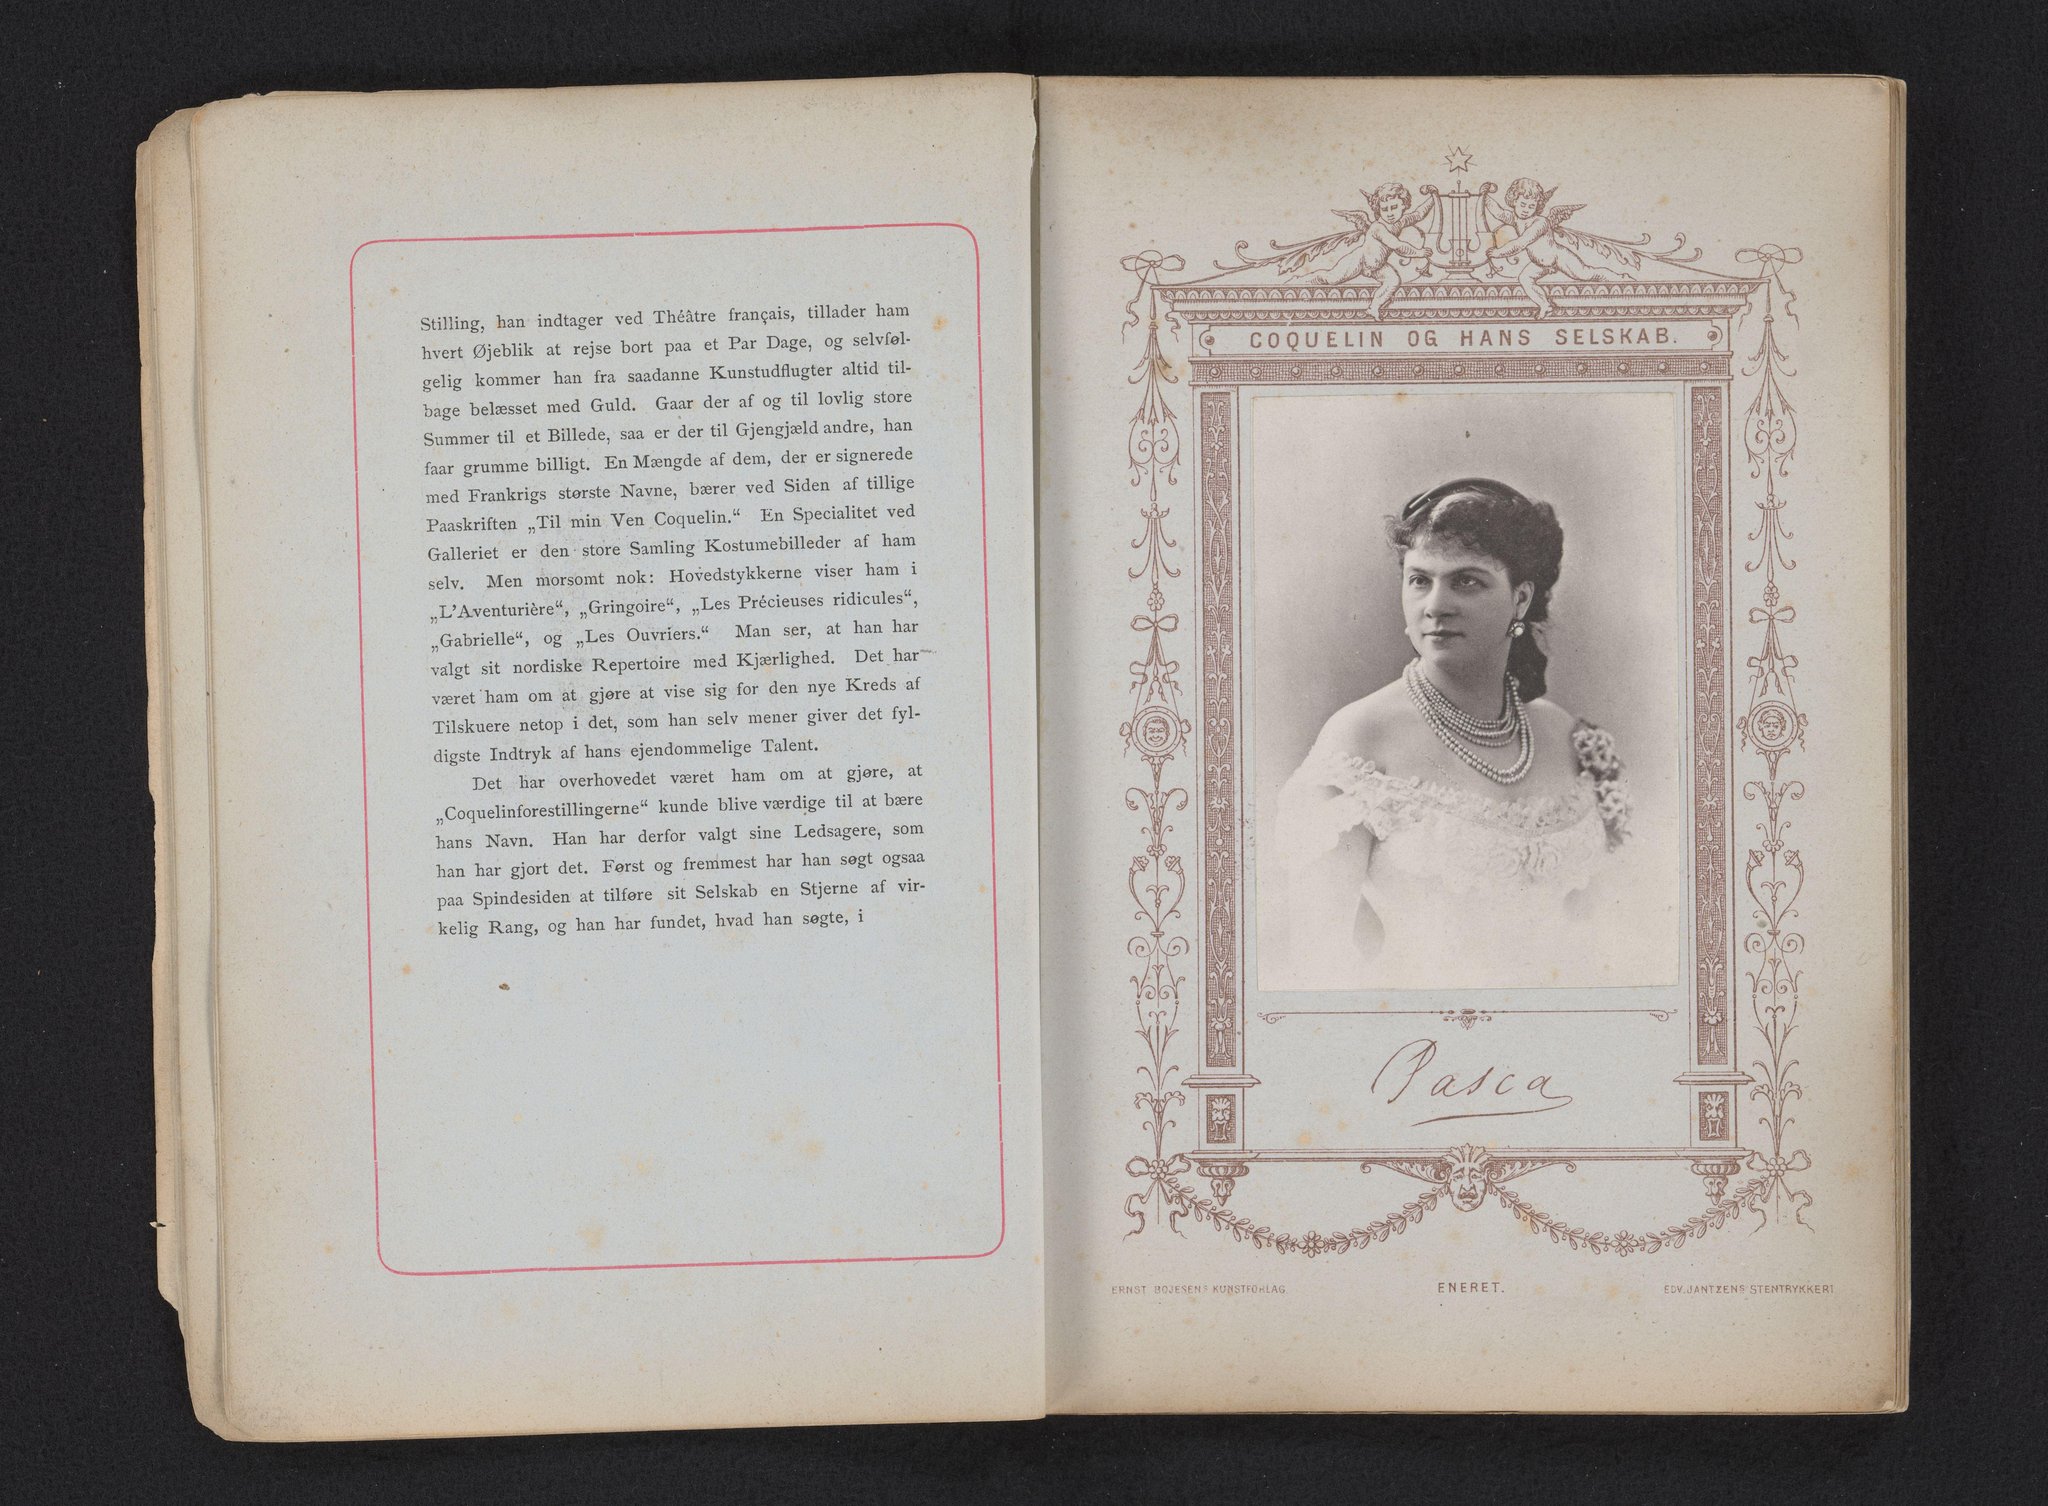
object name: page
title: Portret van Madame Pasca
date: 1872-1882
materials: paper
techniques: photograph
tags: lyon, paris, portrait of opera-singer